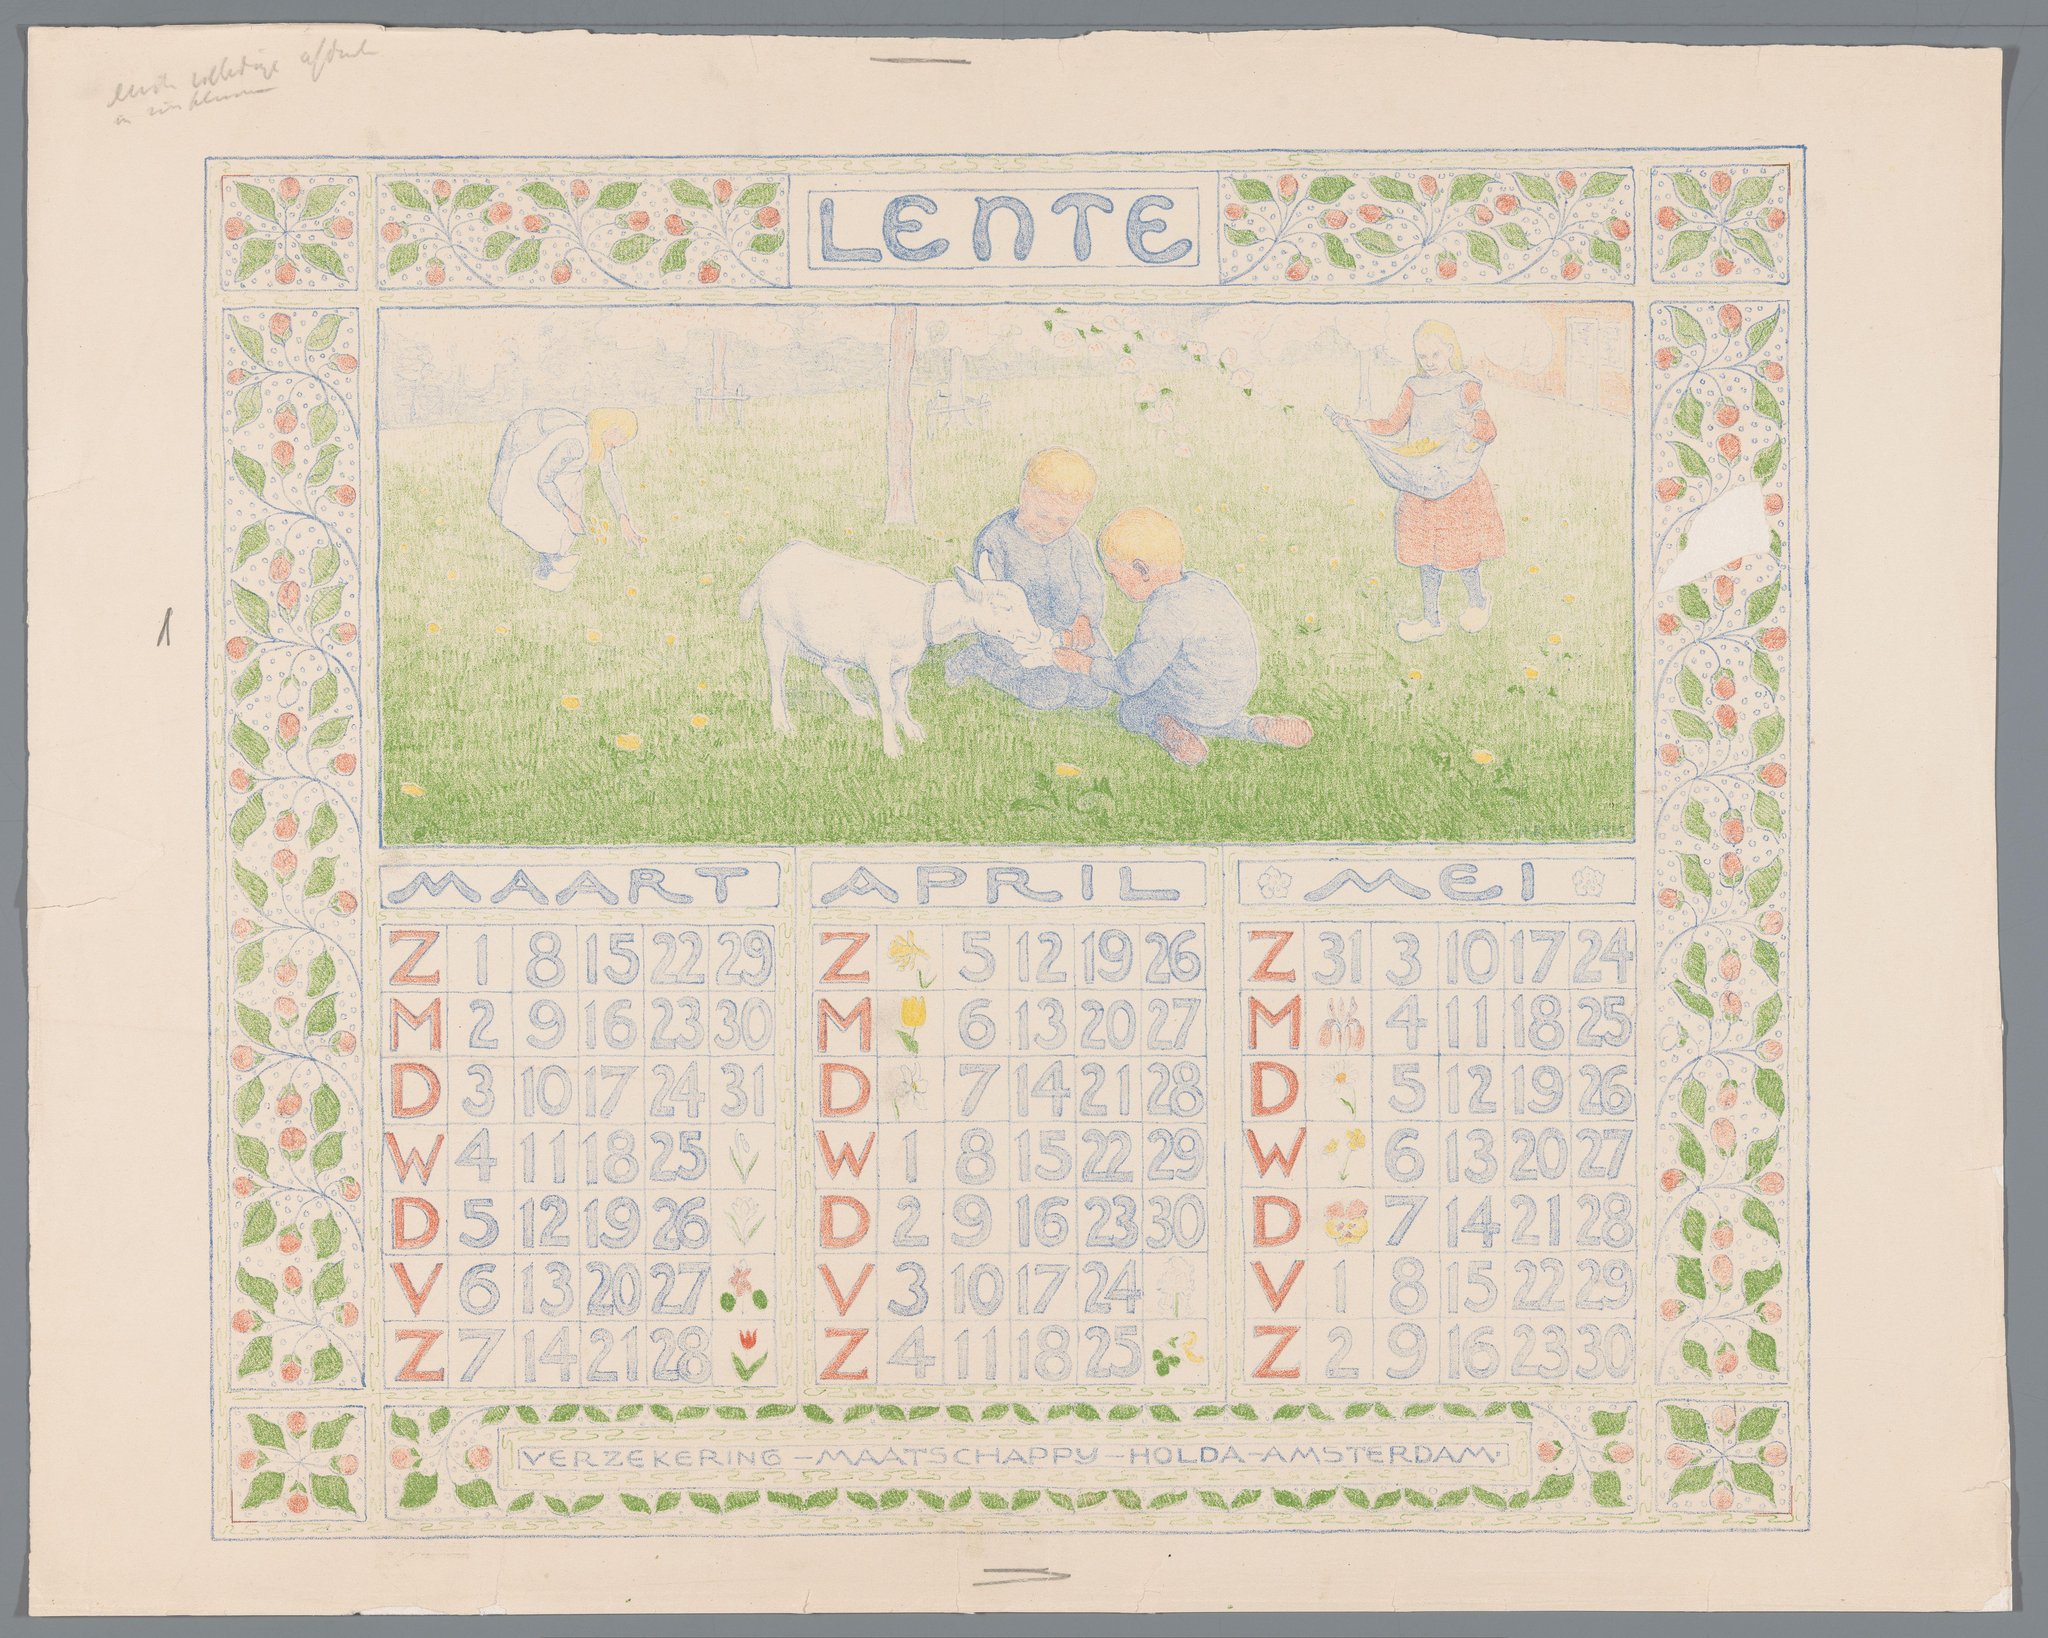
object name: calendar leaf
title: Kalenderblad voor lente 1904 van de Verzekering-Maatschappij Holda in Amsterdam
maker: ferdinand hart nibbrig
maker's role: draughtsman, painter, print maker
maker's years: 1866-1915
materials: paper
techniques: lithograph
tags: picking flowers, spring ~ human activities (the four seasons of the year), orchard, goat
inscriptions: inscription: ‘eerste volledige afdruk in vier kleuren’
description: Een rechthoekig kader opgevuld met de dagen van de maanden maart, april en mei en daarboven twee knielende jongens die een geit voeren in een boomgaard. Op de achtergrond twee meisjes op klompen die bloemen plukken.